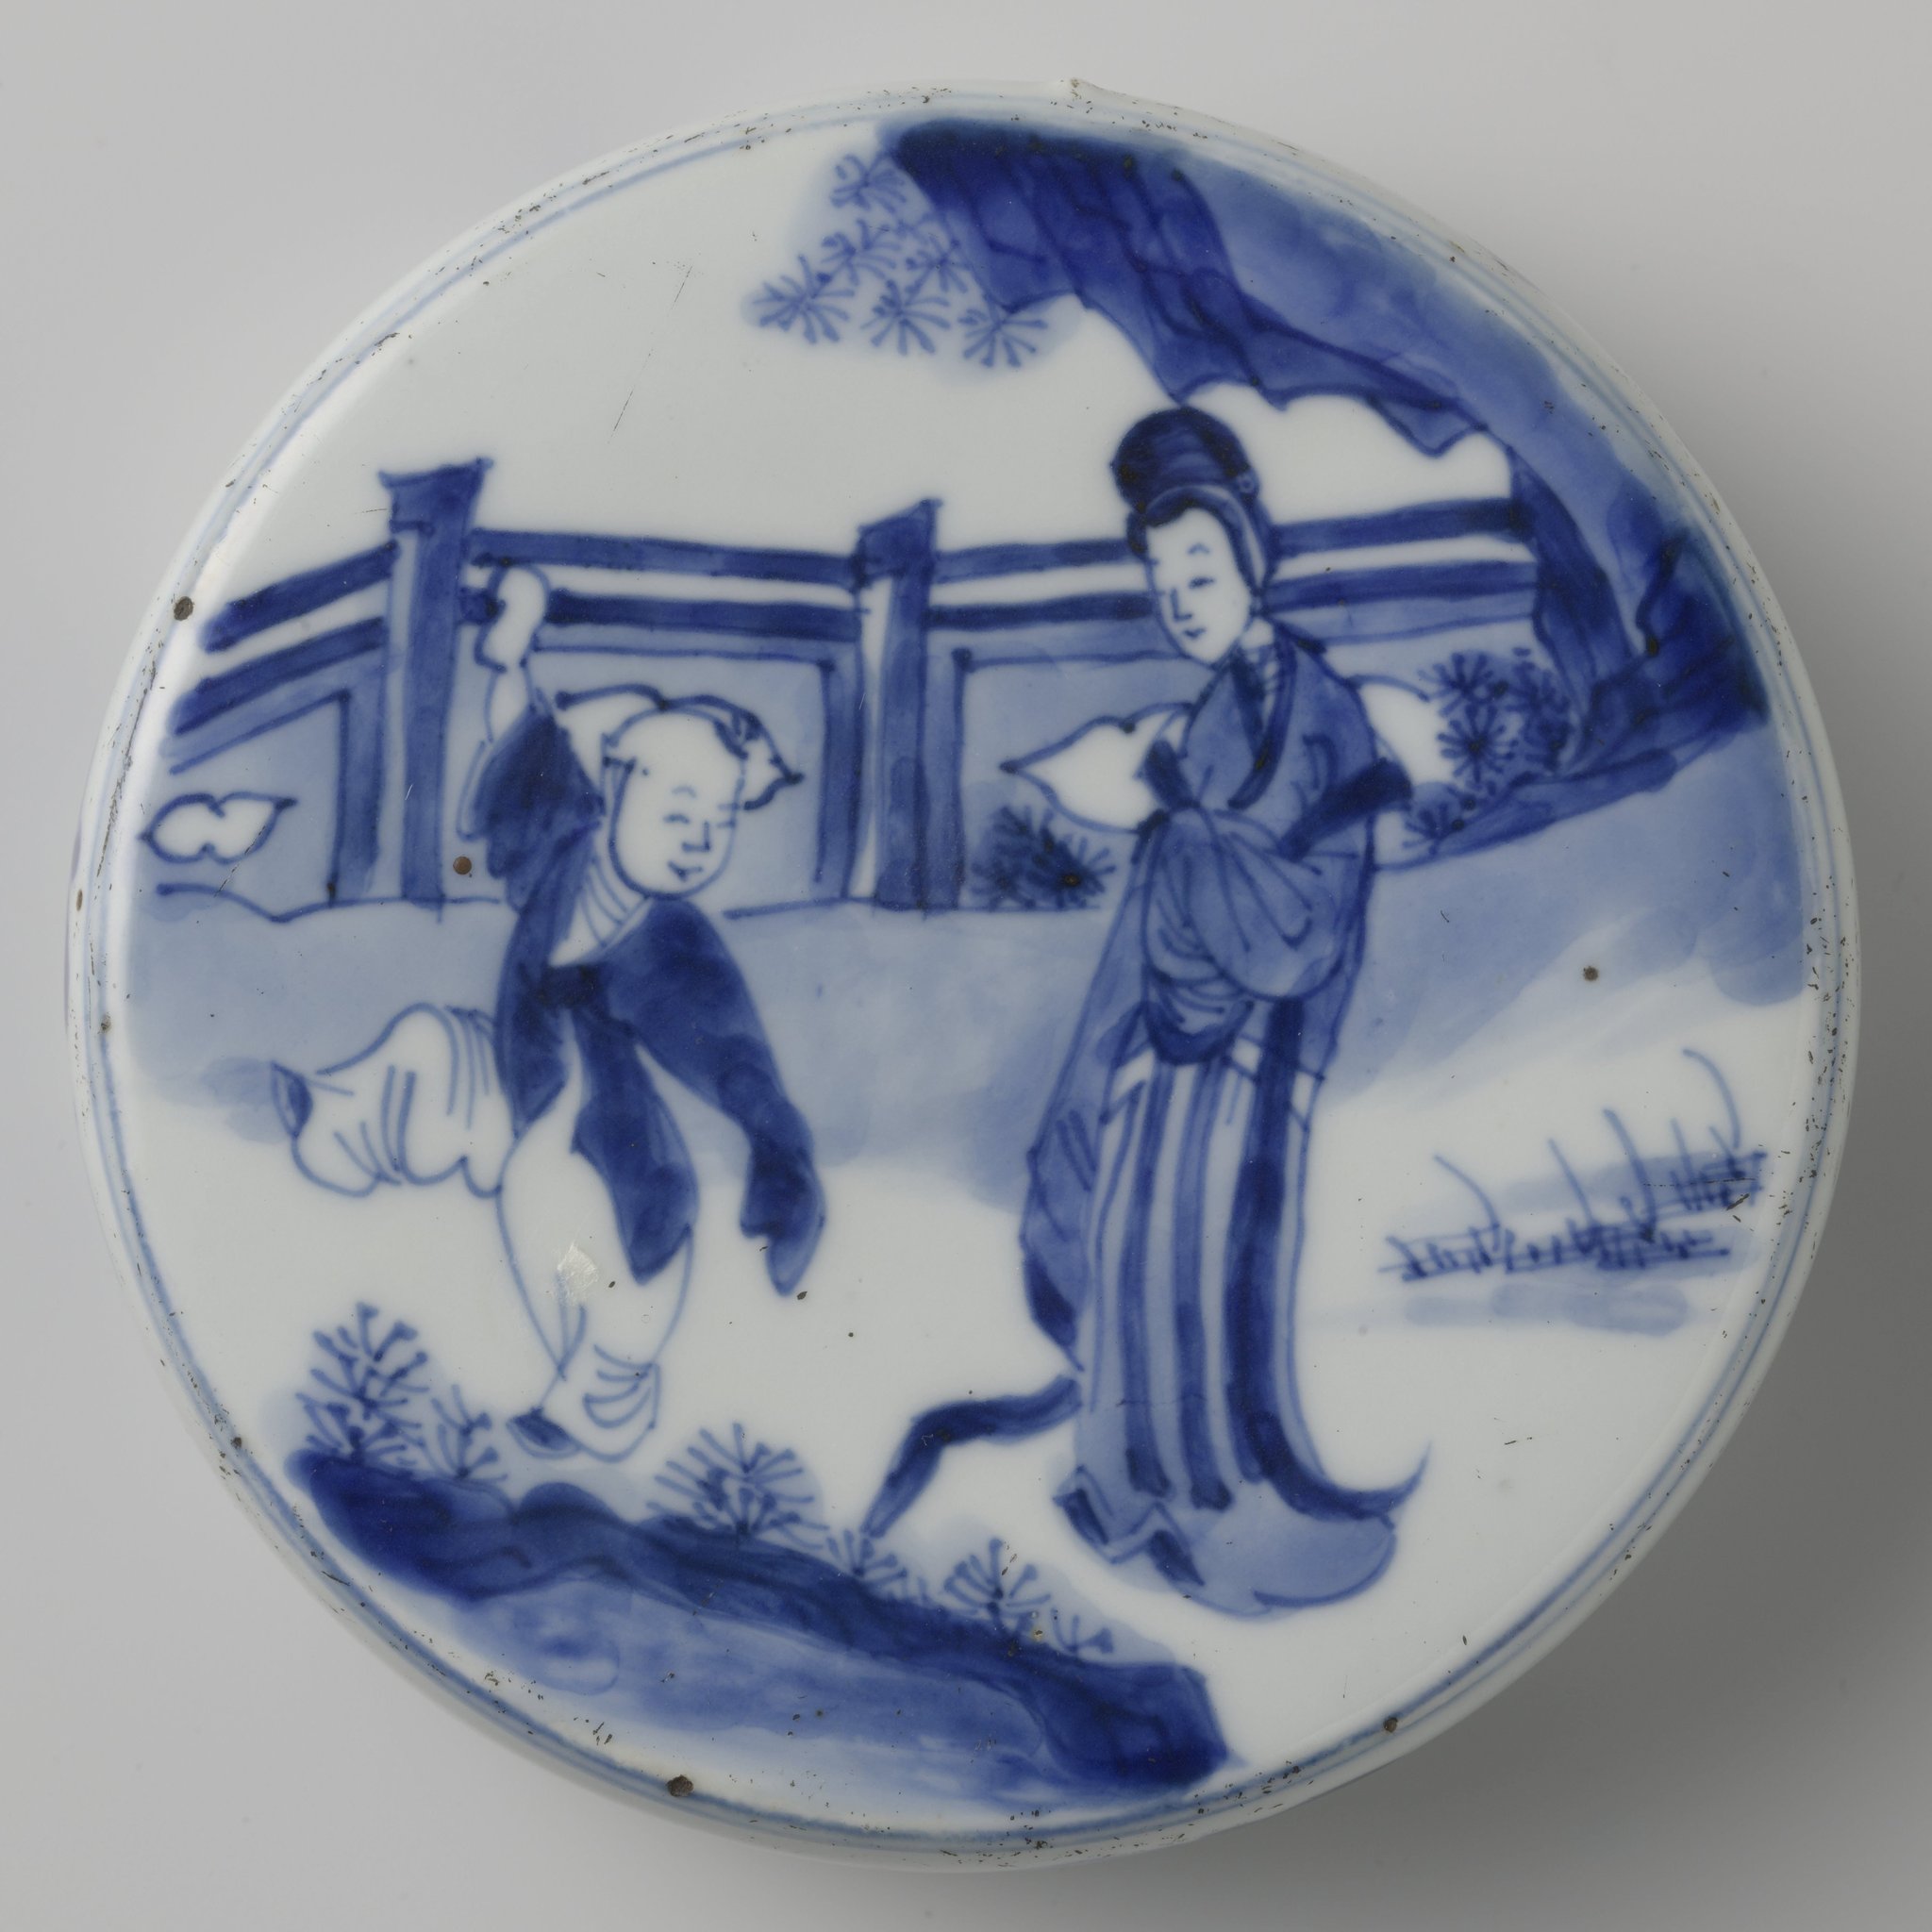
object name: covered jar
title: Ovoid covered jar with fluted sides and figures in medallions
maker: Anonymous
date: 1700-1724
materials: cobalt, glaze, paint, porcelain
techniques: firing, forming, turning, vitrification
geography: china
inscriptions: mark: ‘大 明 成 化 年 製 dà míng Chéng huà nián zhì’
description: Deksel van eivormige dekselpot van porselein, beschilderd in onderglazuur blauw. Op rand van de deksel met bloemtakken, de bovenzijde met een vrouw en jongen (zotje) in een omheinde tuin. Blauw-wit.